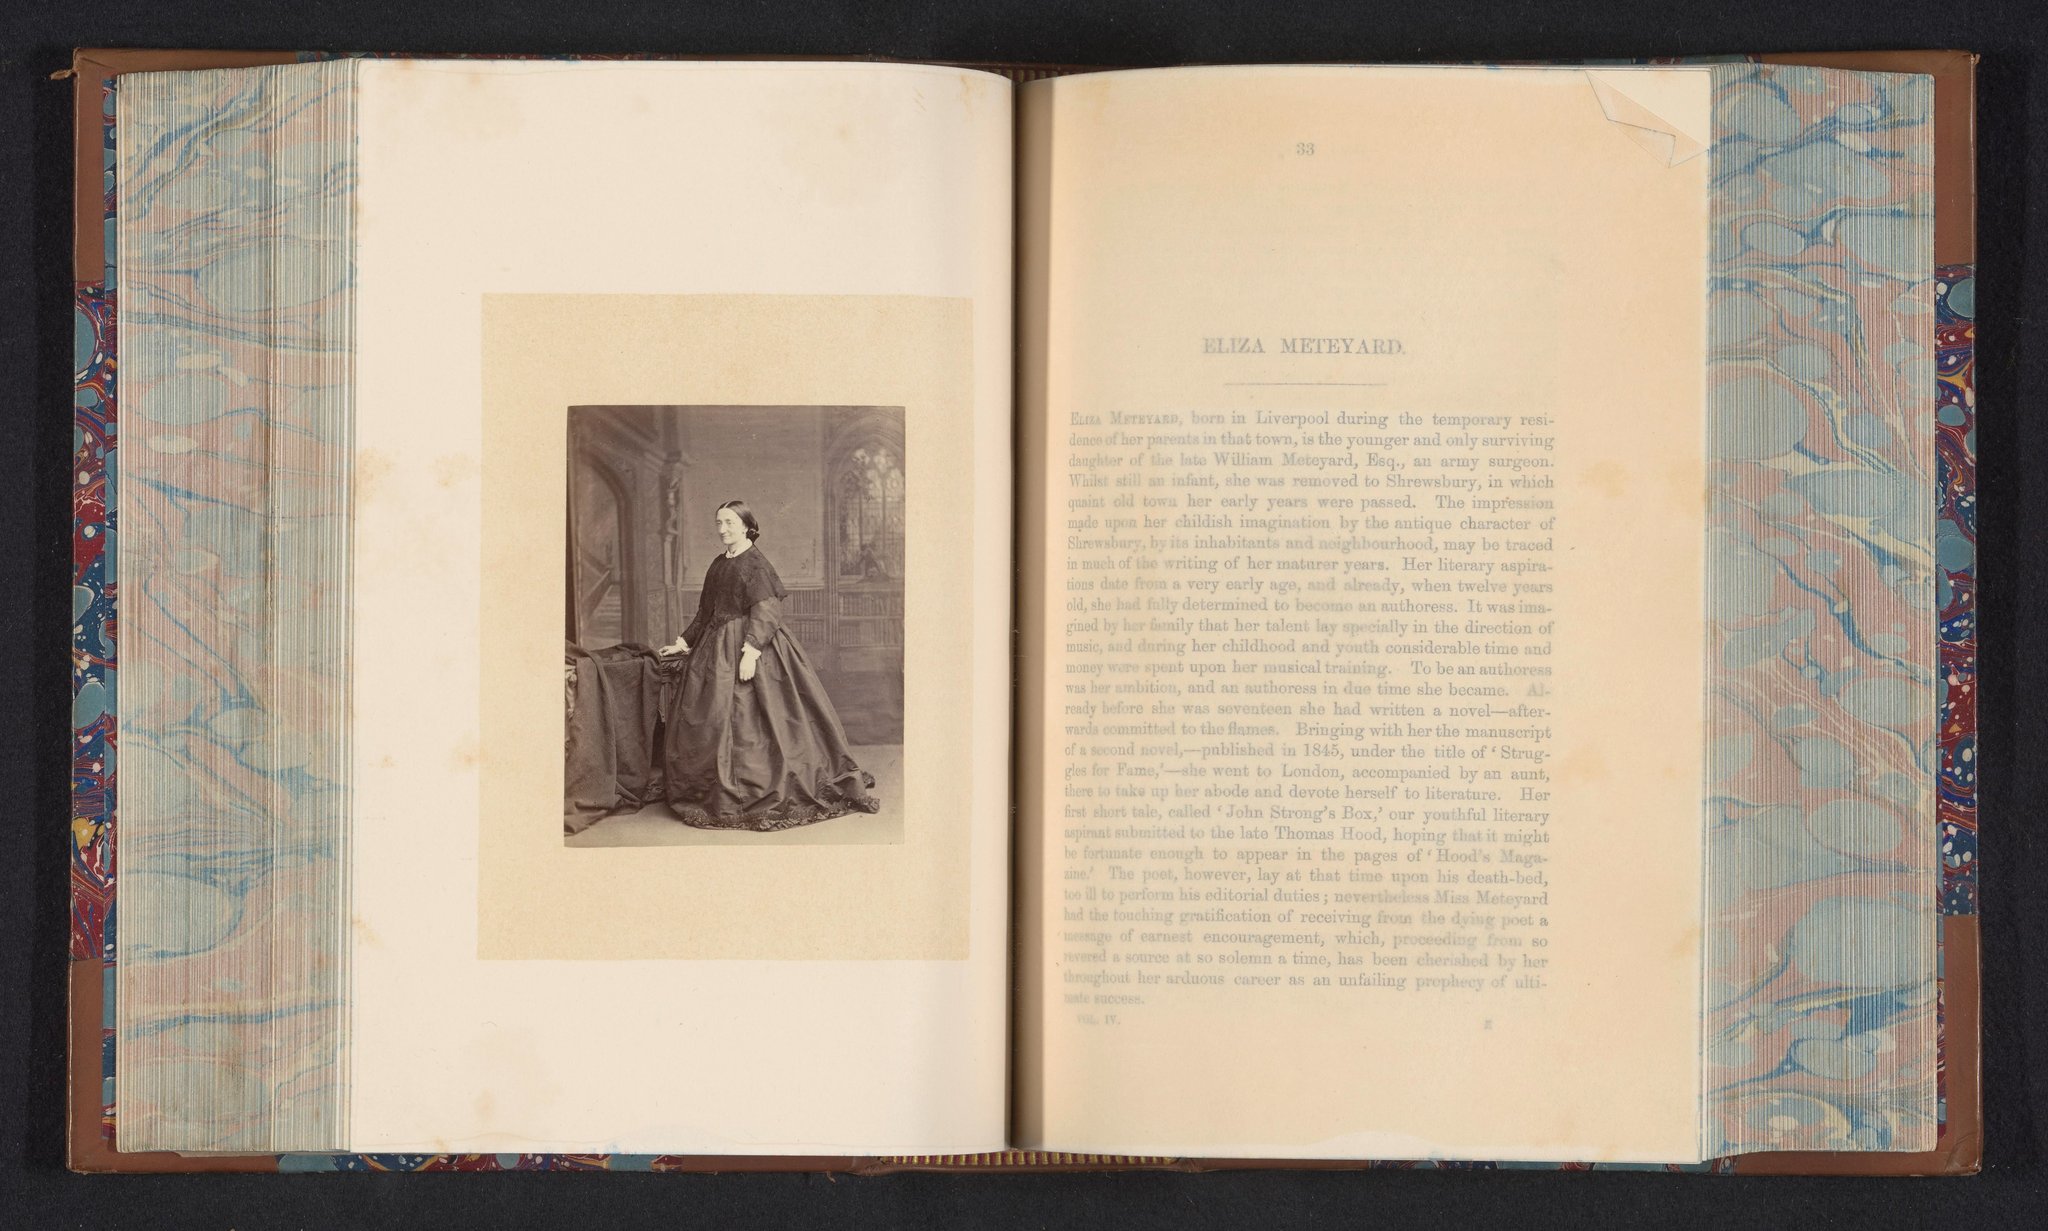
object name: page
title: Portret van Eliza Meteyard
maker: ernest edwards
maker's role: fotograaf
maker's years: 1837-1903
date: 1853-1867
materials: photographic support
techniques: albumen print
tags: eliza meteyard, studio ~ photographer, portrait of a writer